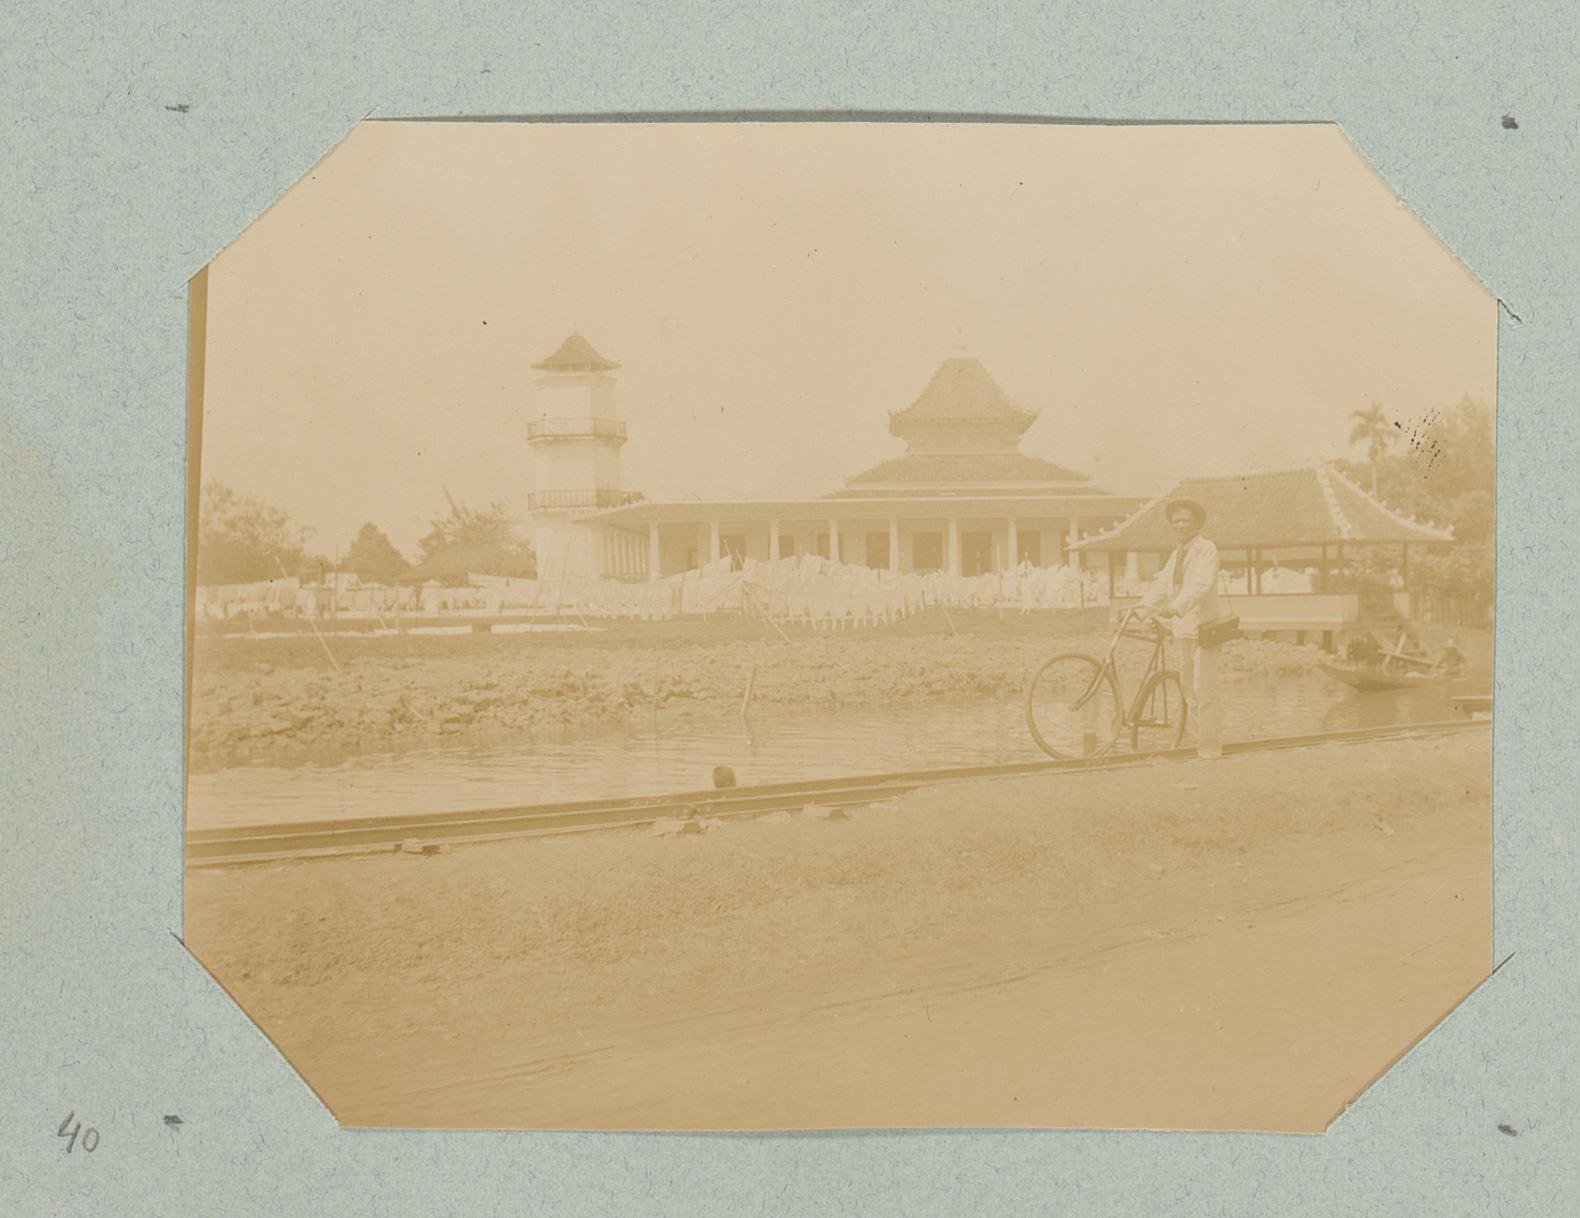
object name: album leaf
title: Man met fiets poseert voor de Masjid Agung, de Grote Moskee van Palembang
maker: Anonymous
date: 1900-1910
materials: paper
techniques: gelatin silver print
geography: dutch east indies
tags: adult man, bicycle, temple, shrine ~ islam, mohammedanism, palembang (city)